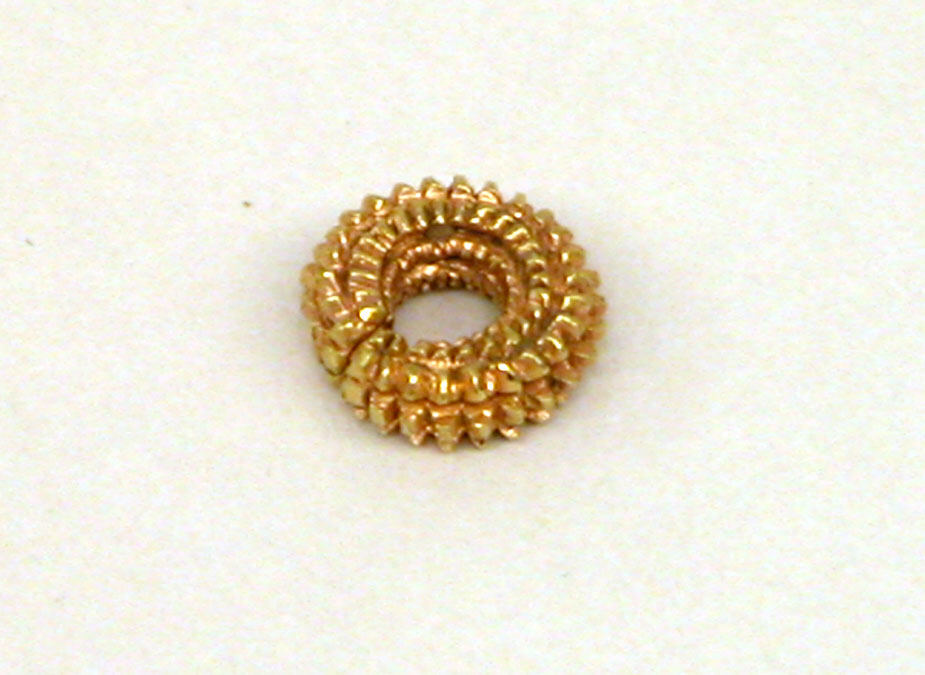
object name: ear ornament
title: Four Ear Ornaments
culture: indonesian, javanese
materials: gold